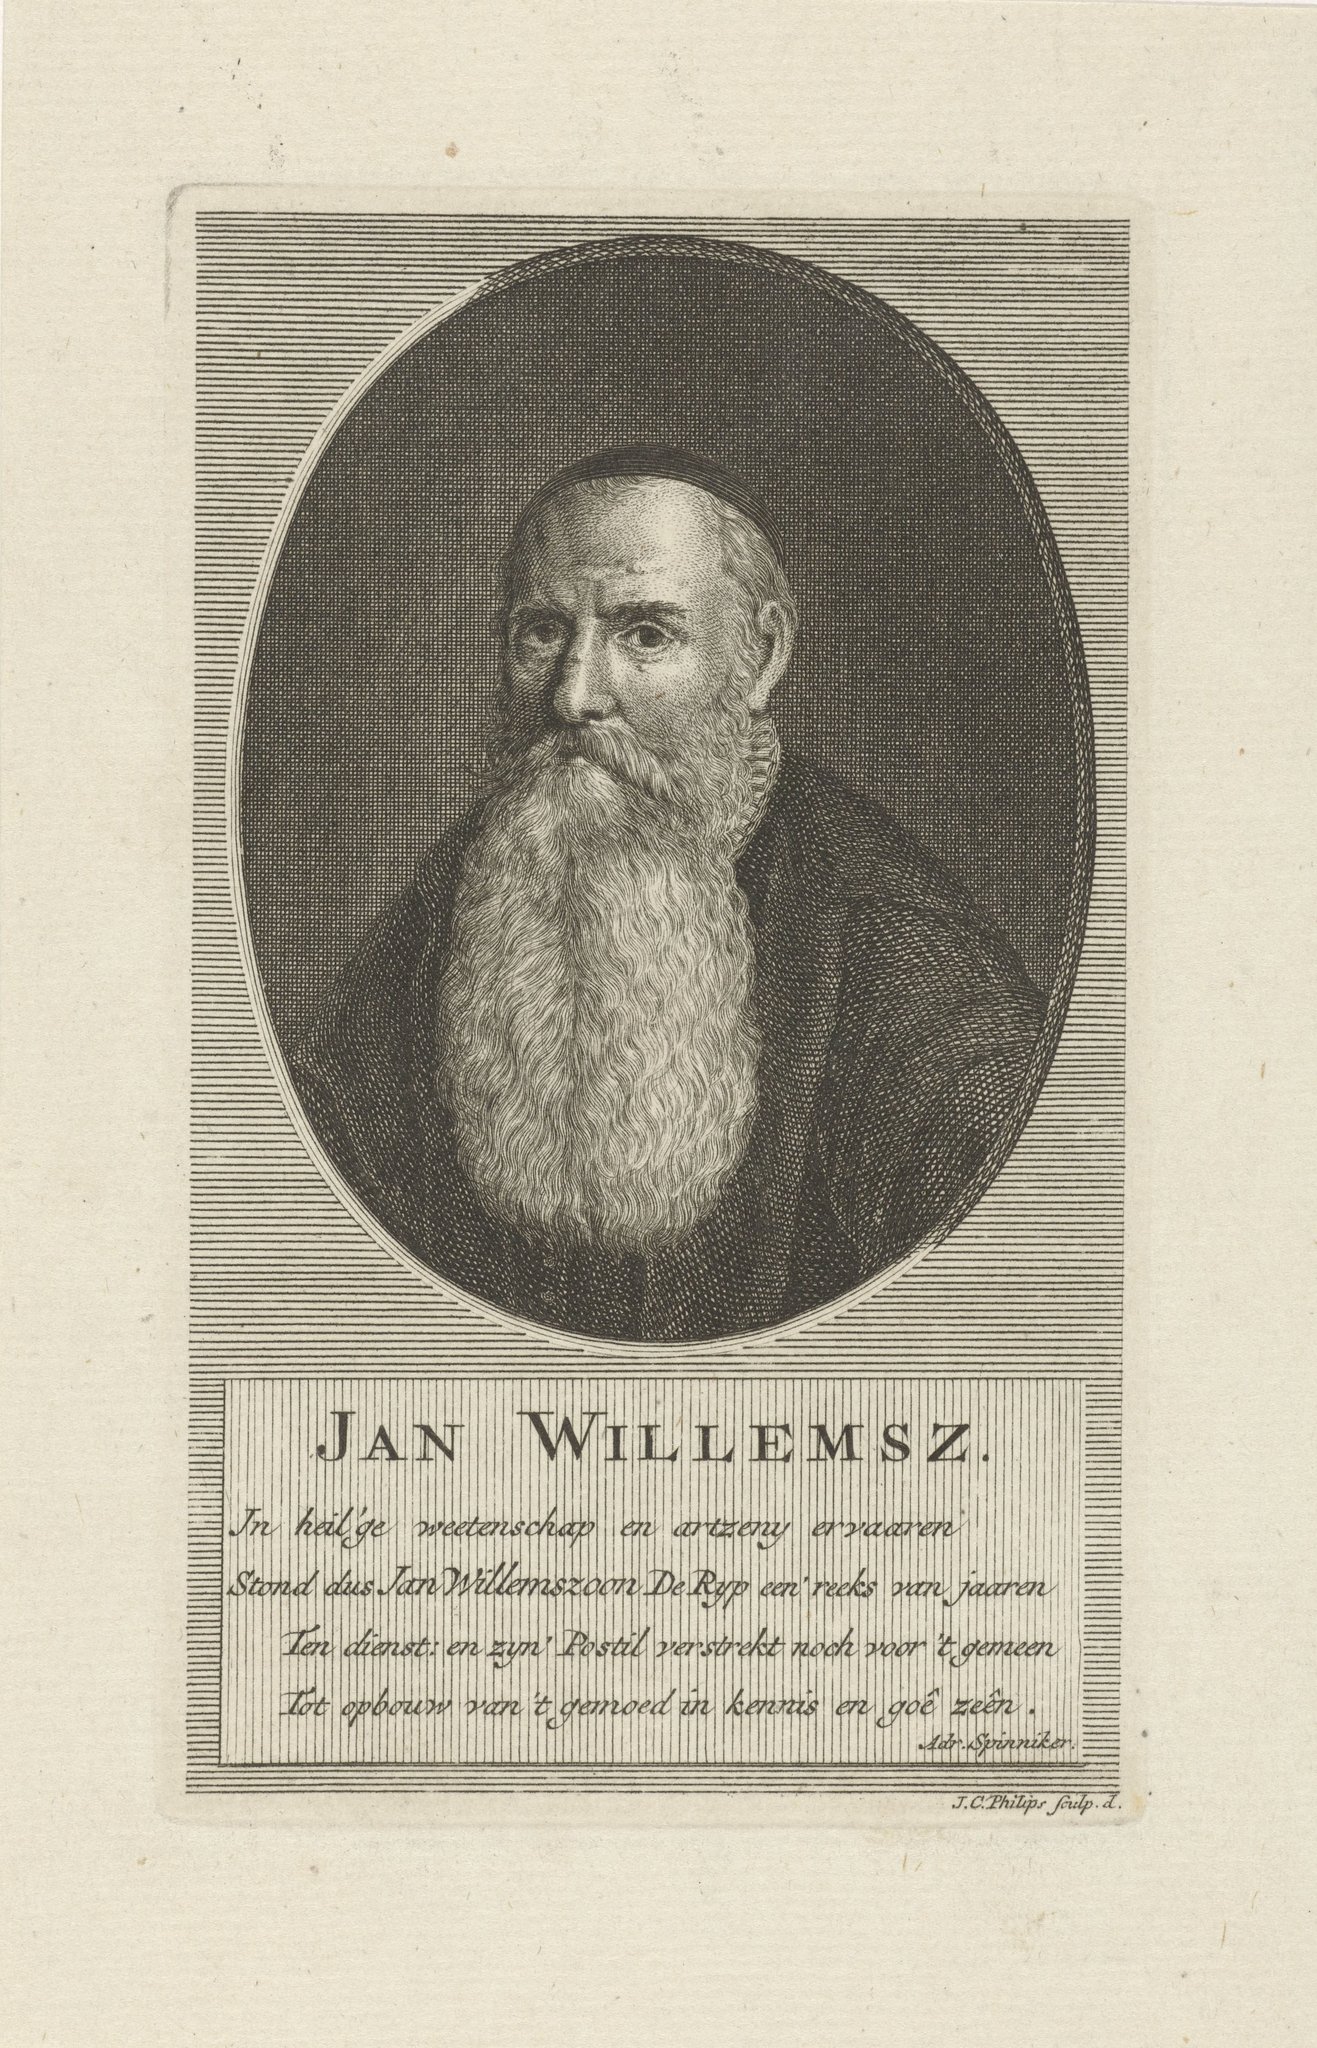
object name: print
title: Portret van de doopsgezinde predikant Jan Willemsz.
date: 1736-1743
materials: paper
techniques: engraving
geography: amsterdam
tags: predikant, arts, jan willemsz.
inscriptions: collector's mark: Lugt 2228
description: Portret van de doopsgezinde predikant Jan Willemsz. In het kader een vierregelig lofdicht in het Nederlands.